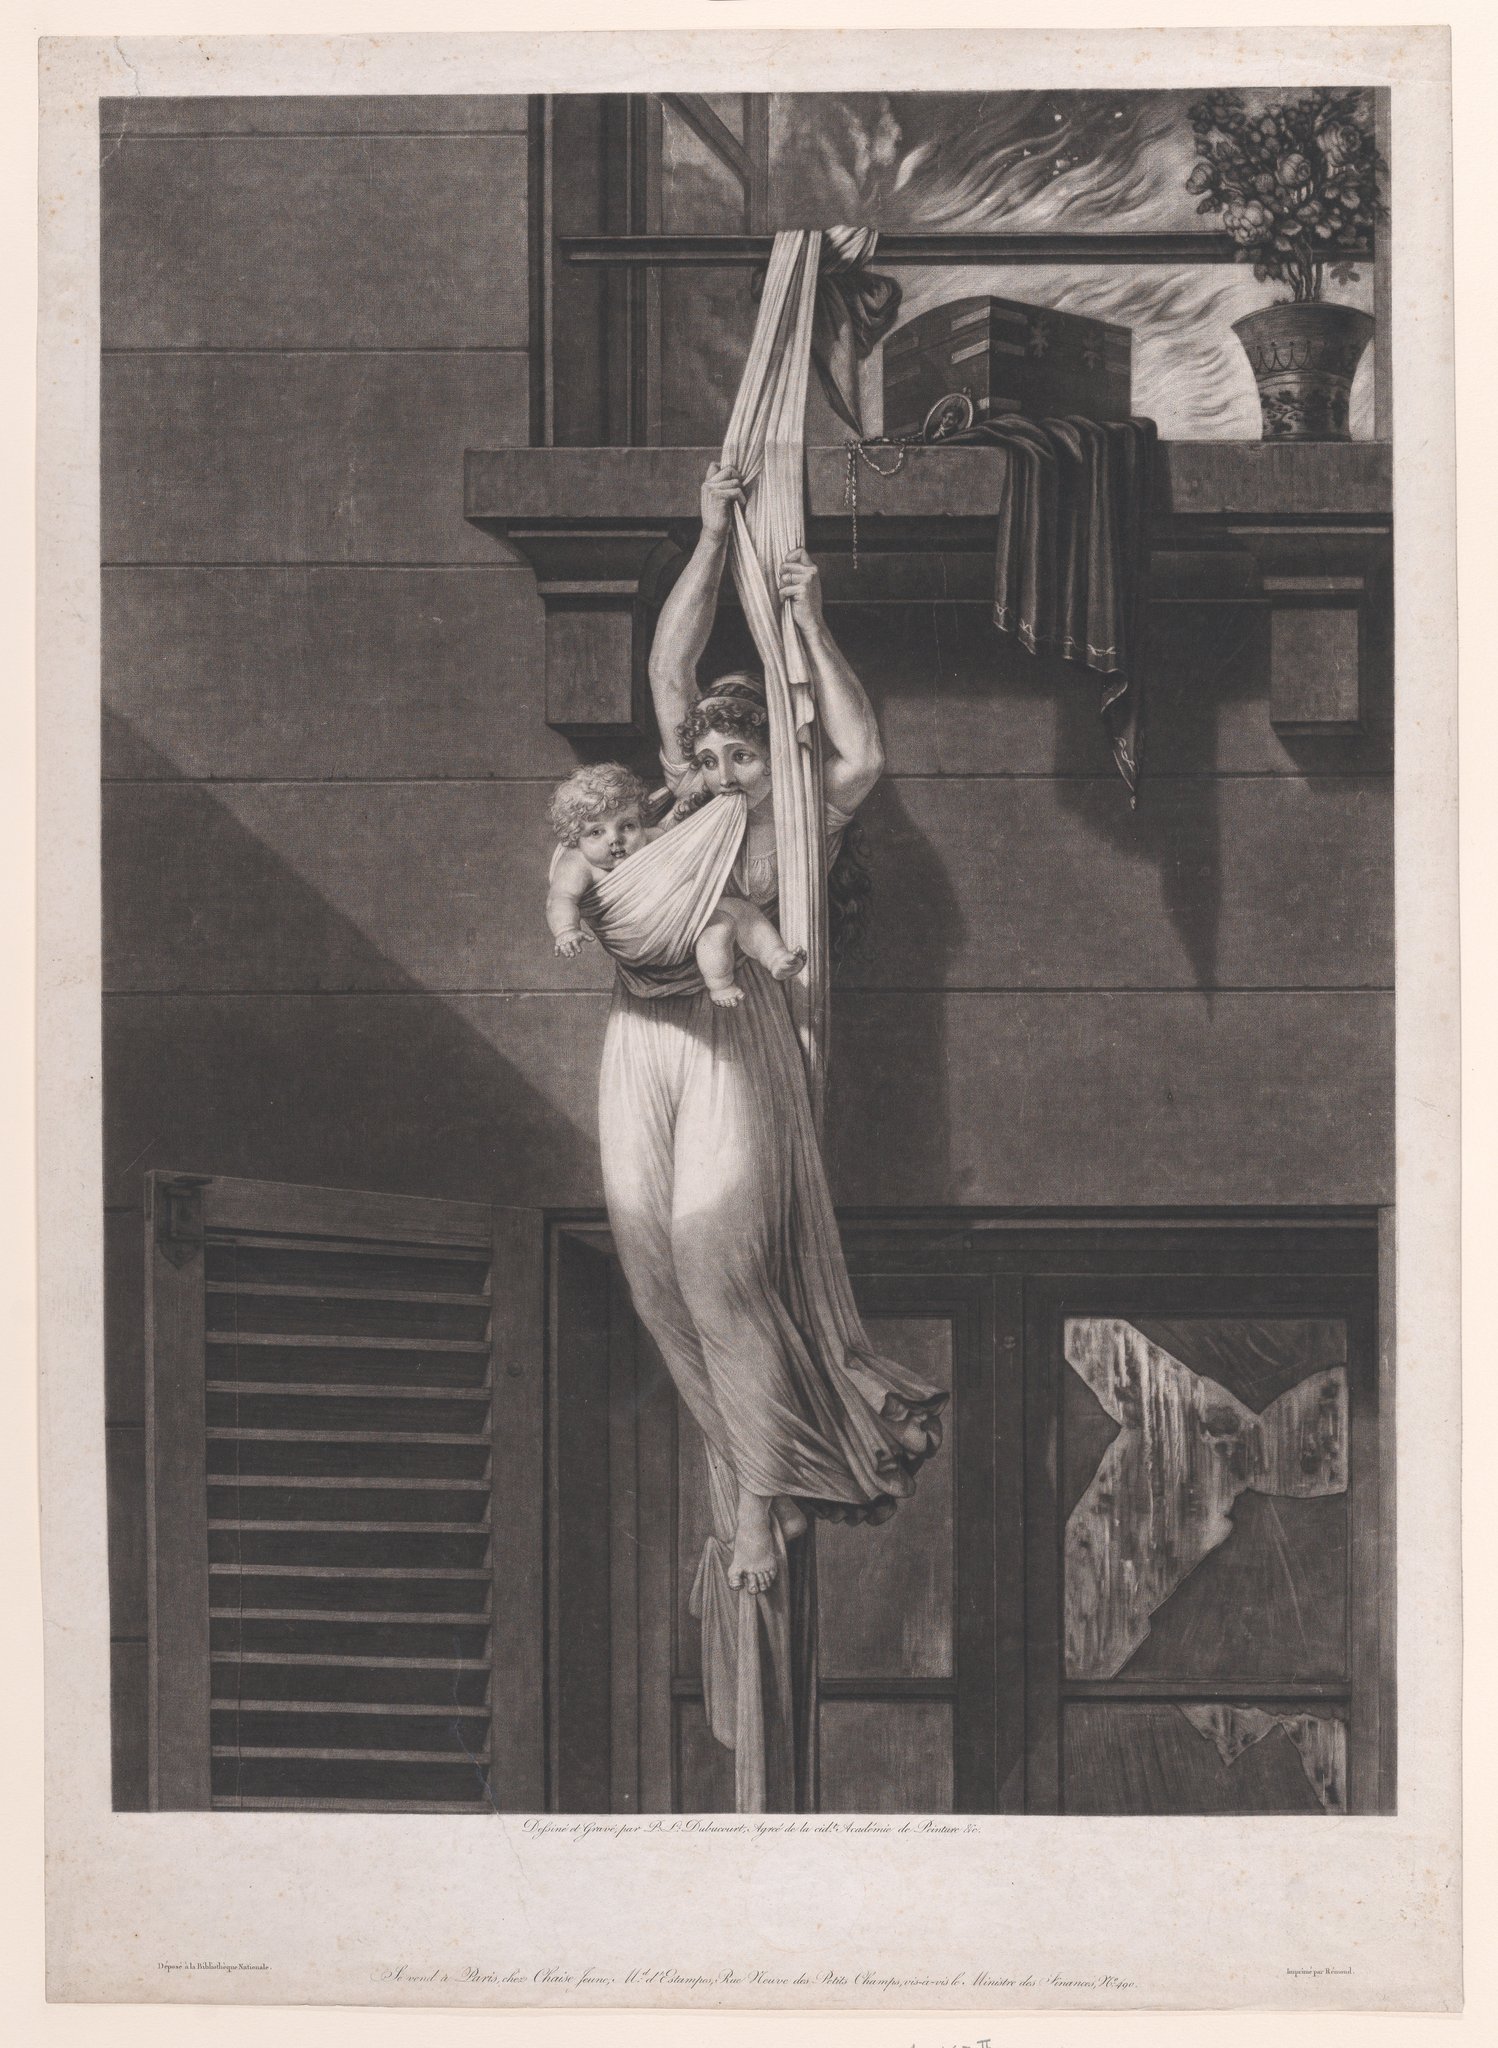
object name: print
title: The Fire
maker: louis philibert debucourt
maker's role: artist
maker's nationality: french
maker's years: 1755-1832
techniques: mezzotint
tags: windows,infants,women,fire